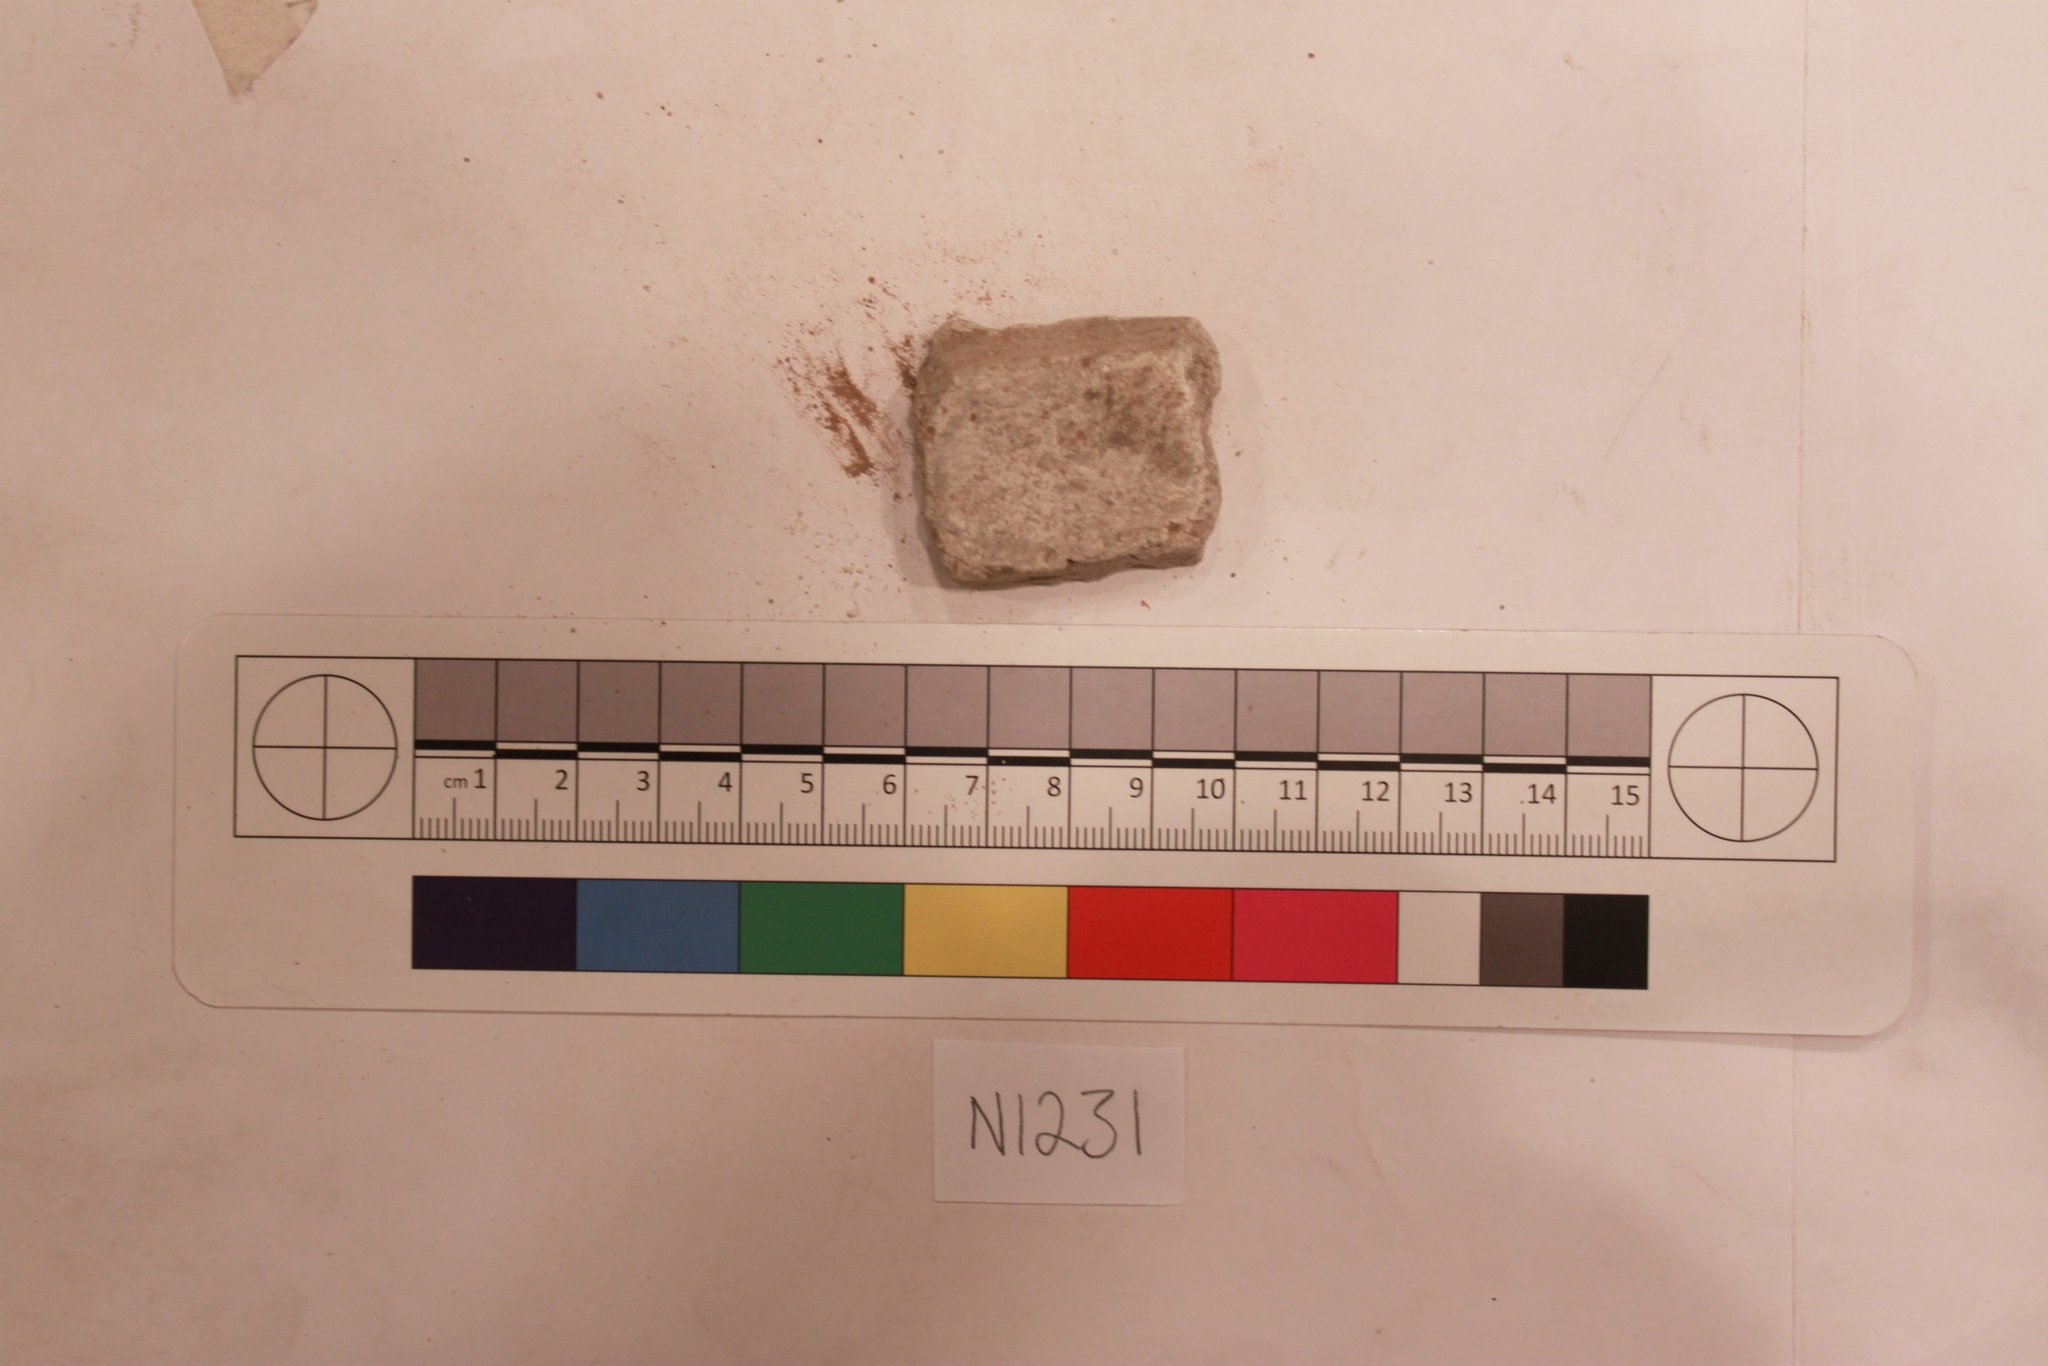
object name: fragment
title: Stucco Fragment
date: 701-1200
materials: plaster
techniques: carving, painting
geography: iran